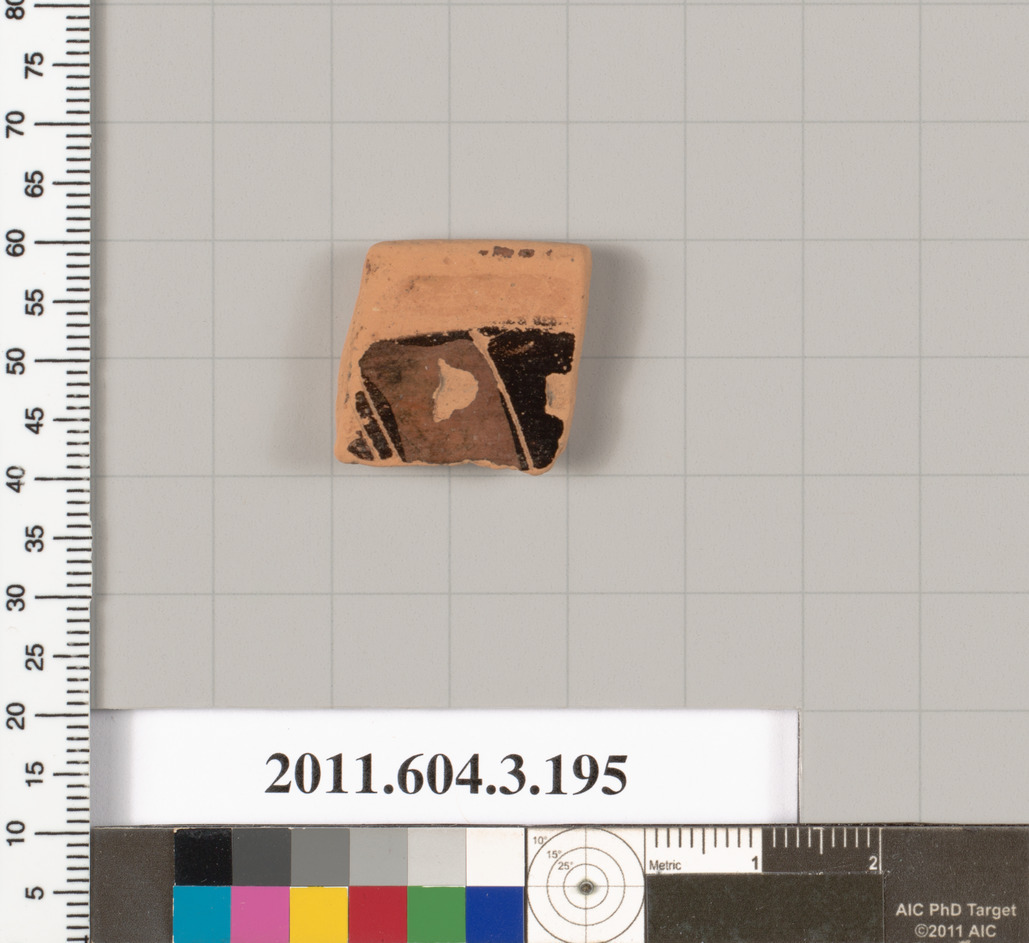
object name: undetermined shape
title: Terracotta fragment of an undetermined shape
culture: greek, attic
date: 534-501 BCE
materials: terracotta